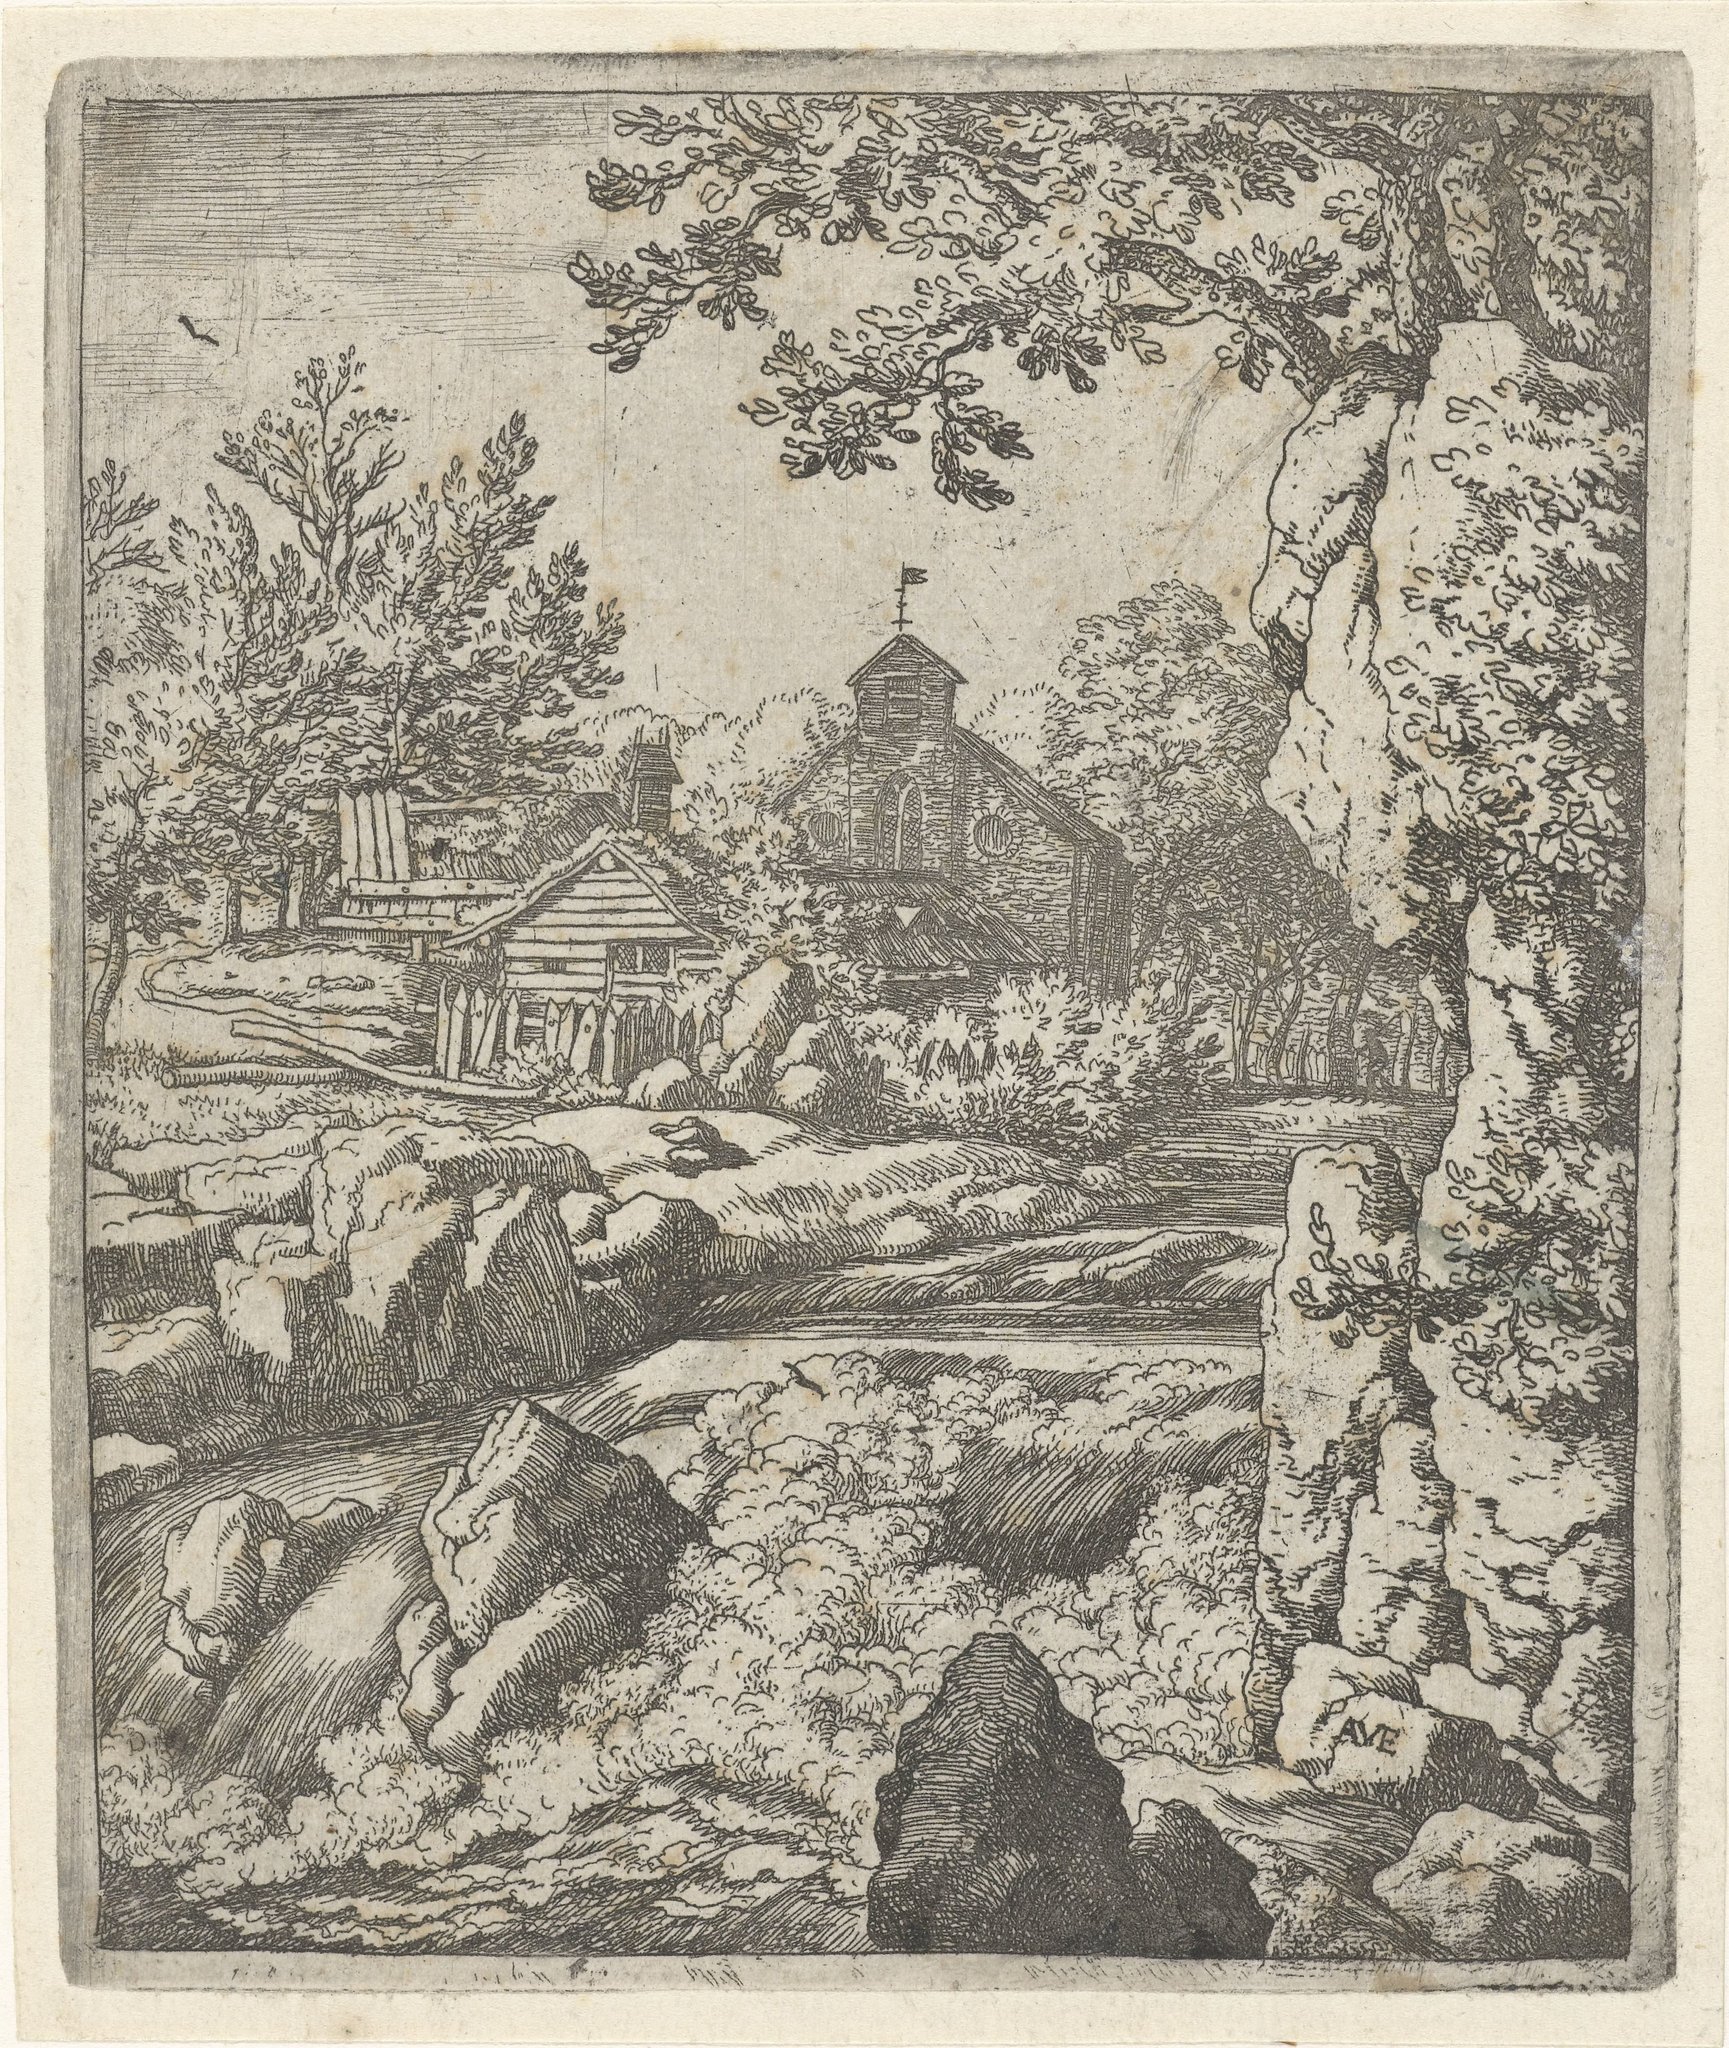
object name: print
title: Landschap met kerk en waterval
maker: allaert van everdingen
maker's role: draughtsman, painter, print maker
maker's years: 1621-1675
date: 1651-1675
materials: paper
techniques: etching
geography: netherlands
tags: waterfall